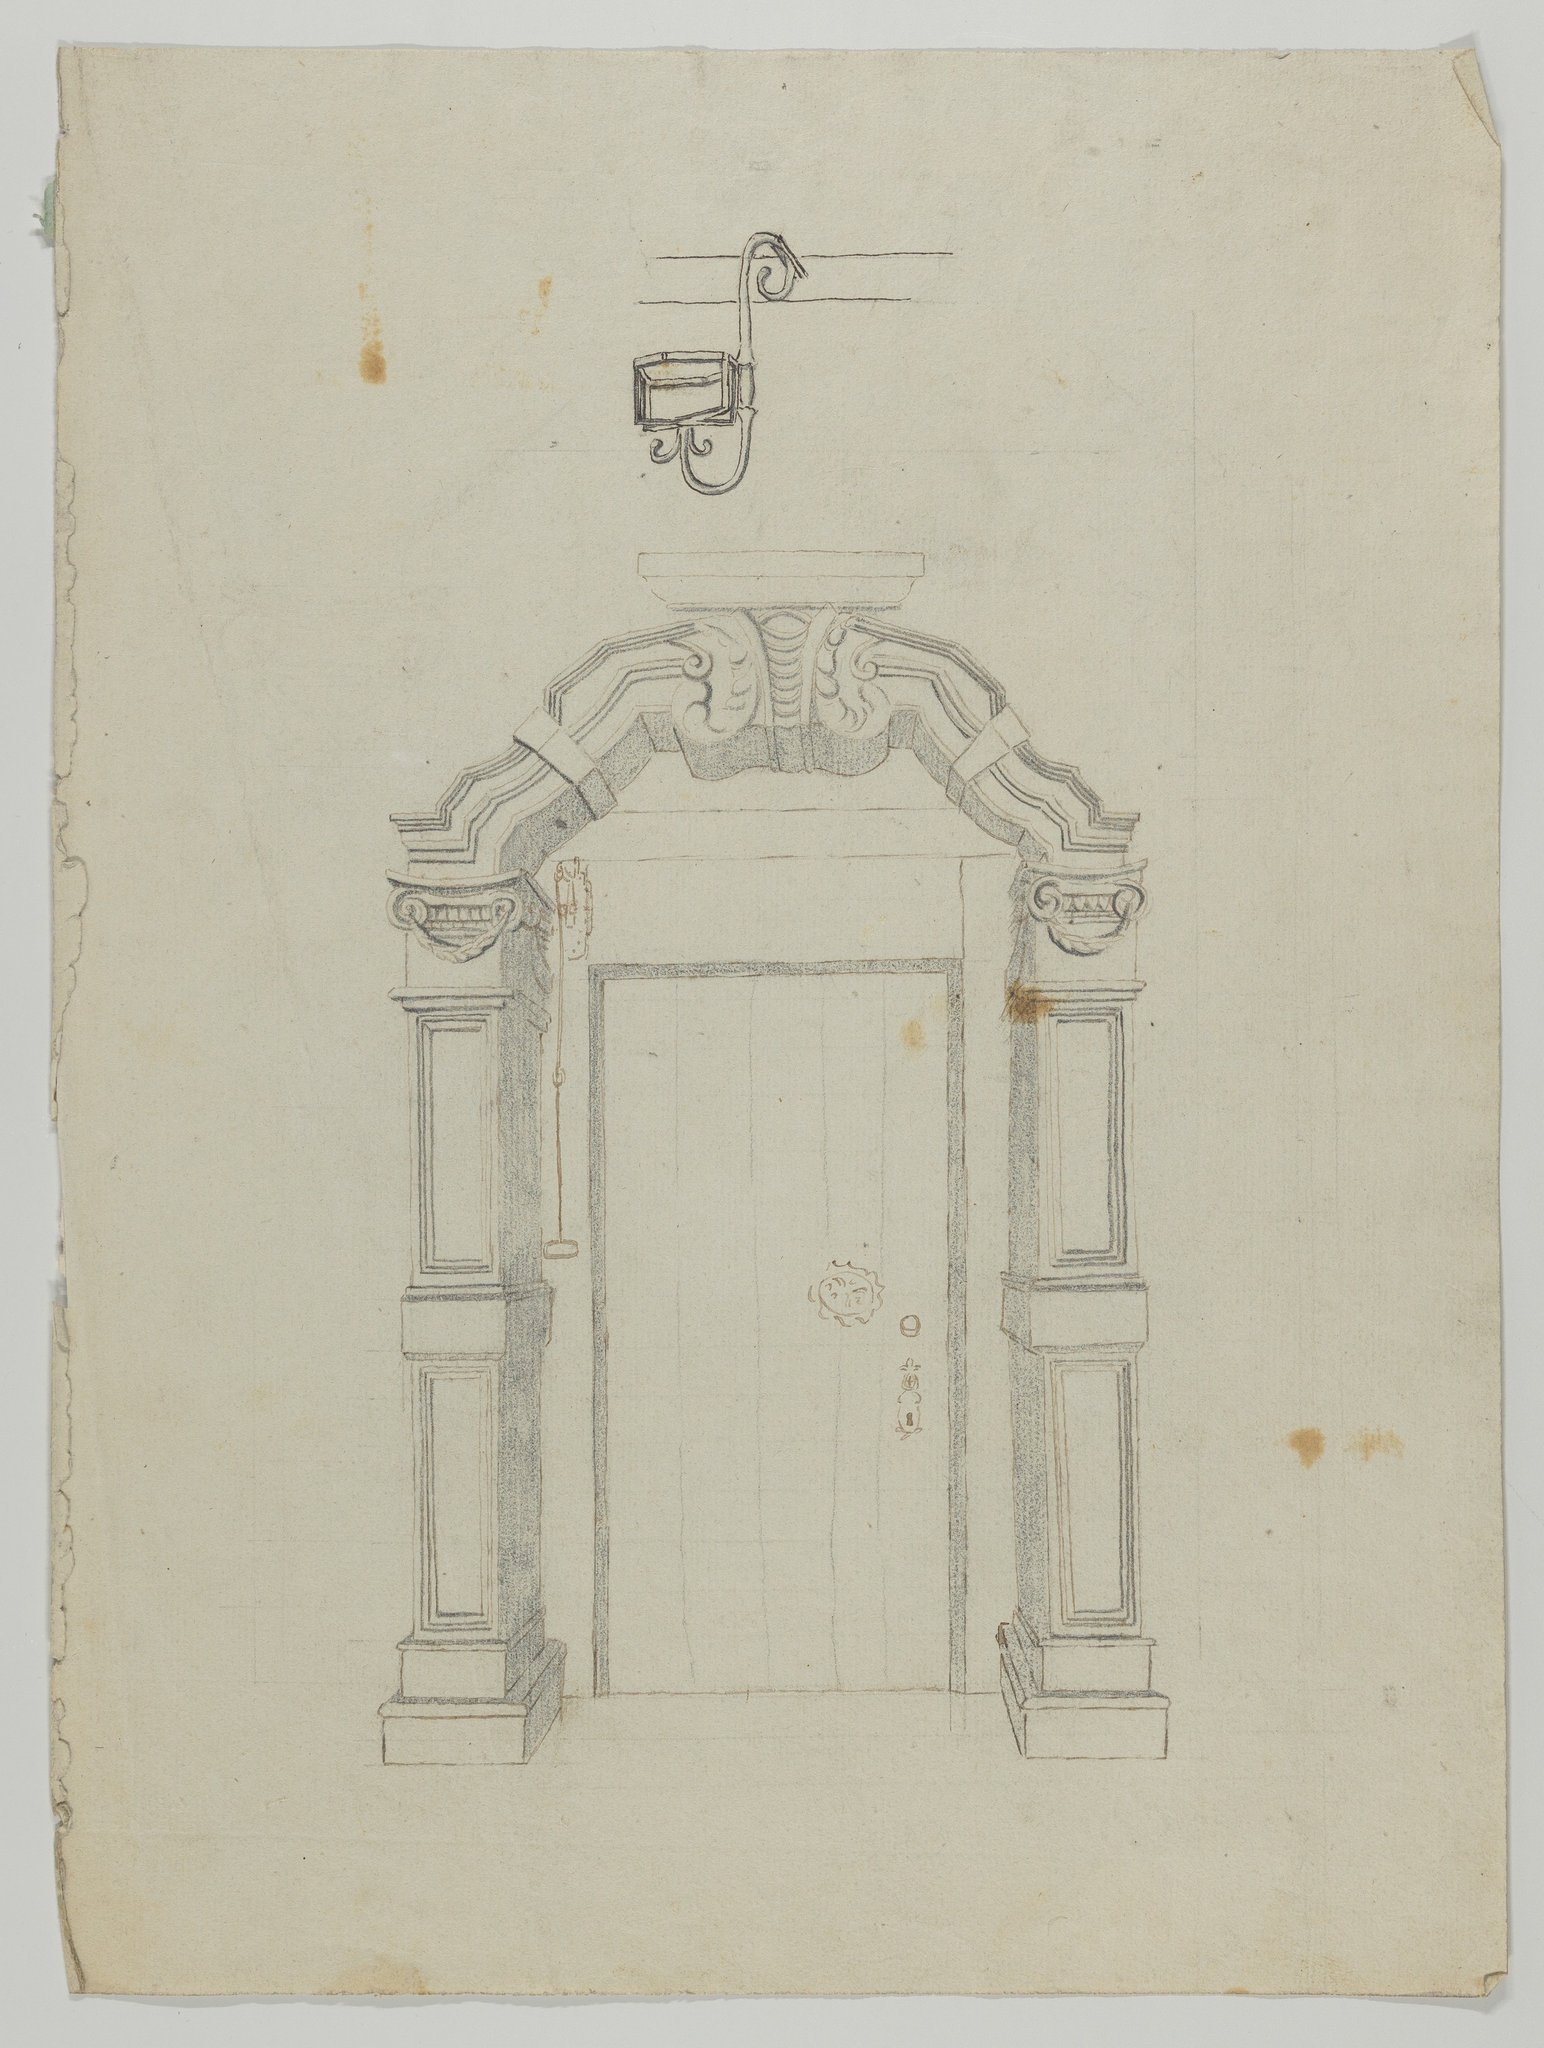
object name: drawing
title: Design for a Door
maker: anonymous, flemish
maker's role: artist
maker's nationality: flemish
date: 1700-1725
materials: chalk, ink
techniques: pen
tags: doors